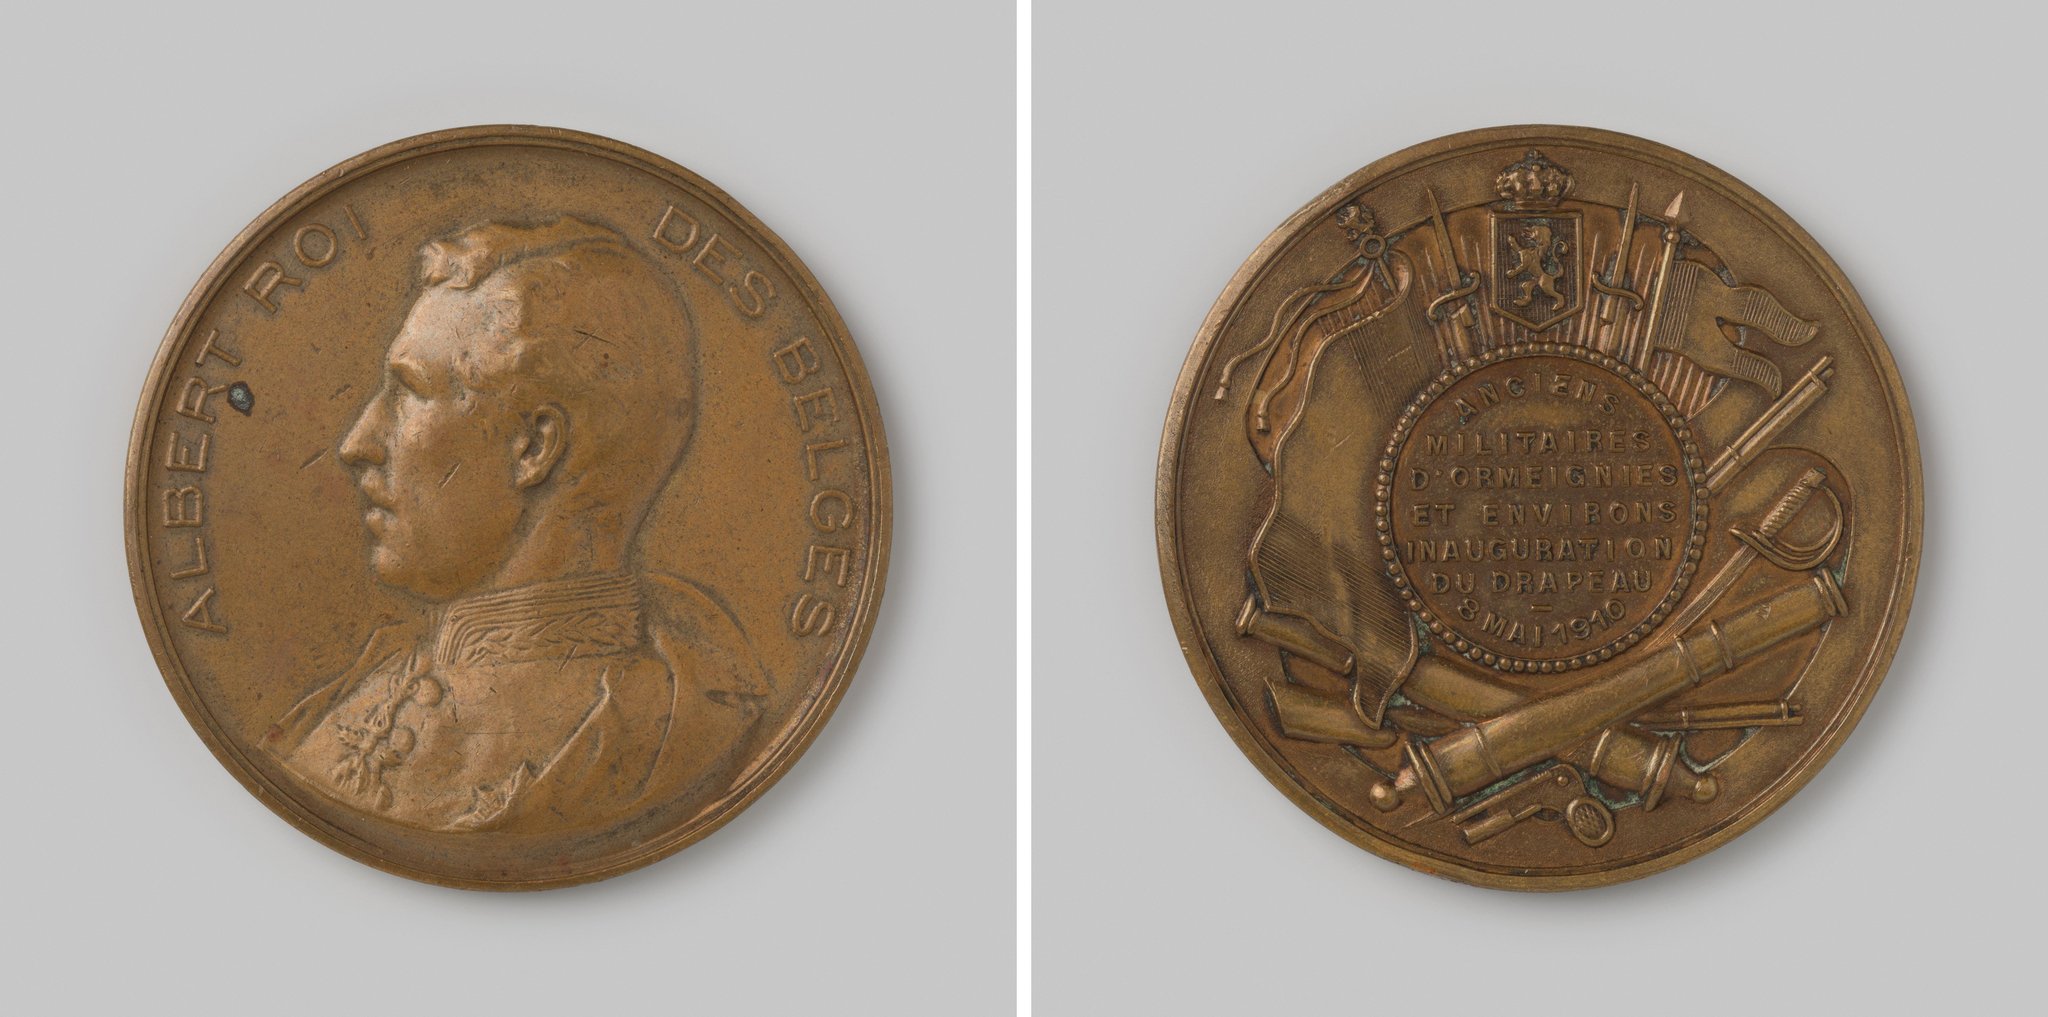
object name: history medal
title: Inwijding van de vlag van de Oud-Militairen van Ormeignies 1910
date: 1910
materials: bronze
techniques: striking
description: Bronzen penning, op de voorzijde het borstbeeld van Koning Albert naar links met omschrift, op de keerzijde een medaillon met zeven regels tekst te midden van krijgsbenodigdheden waaronder links een grote vlag.